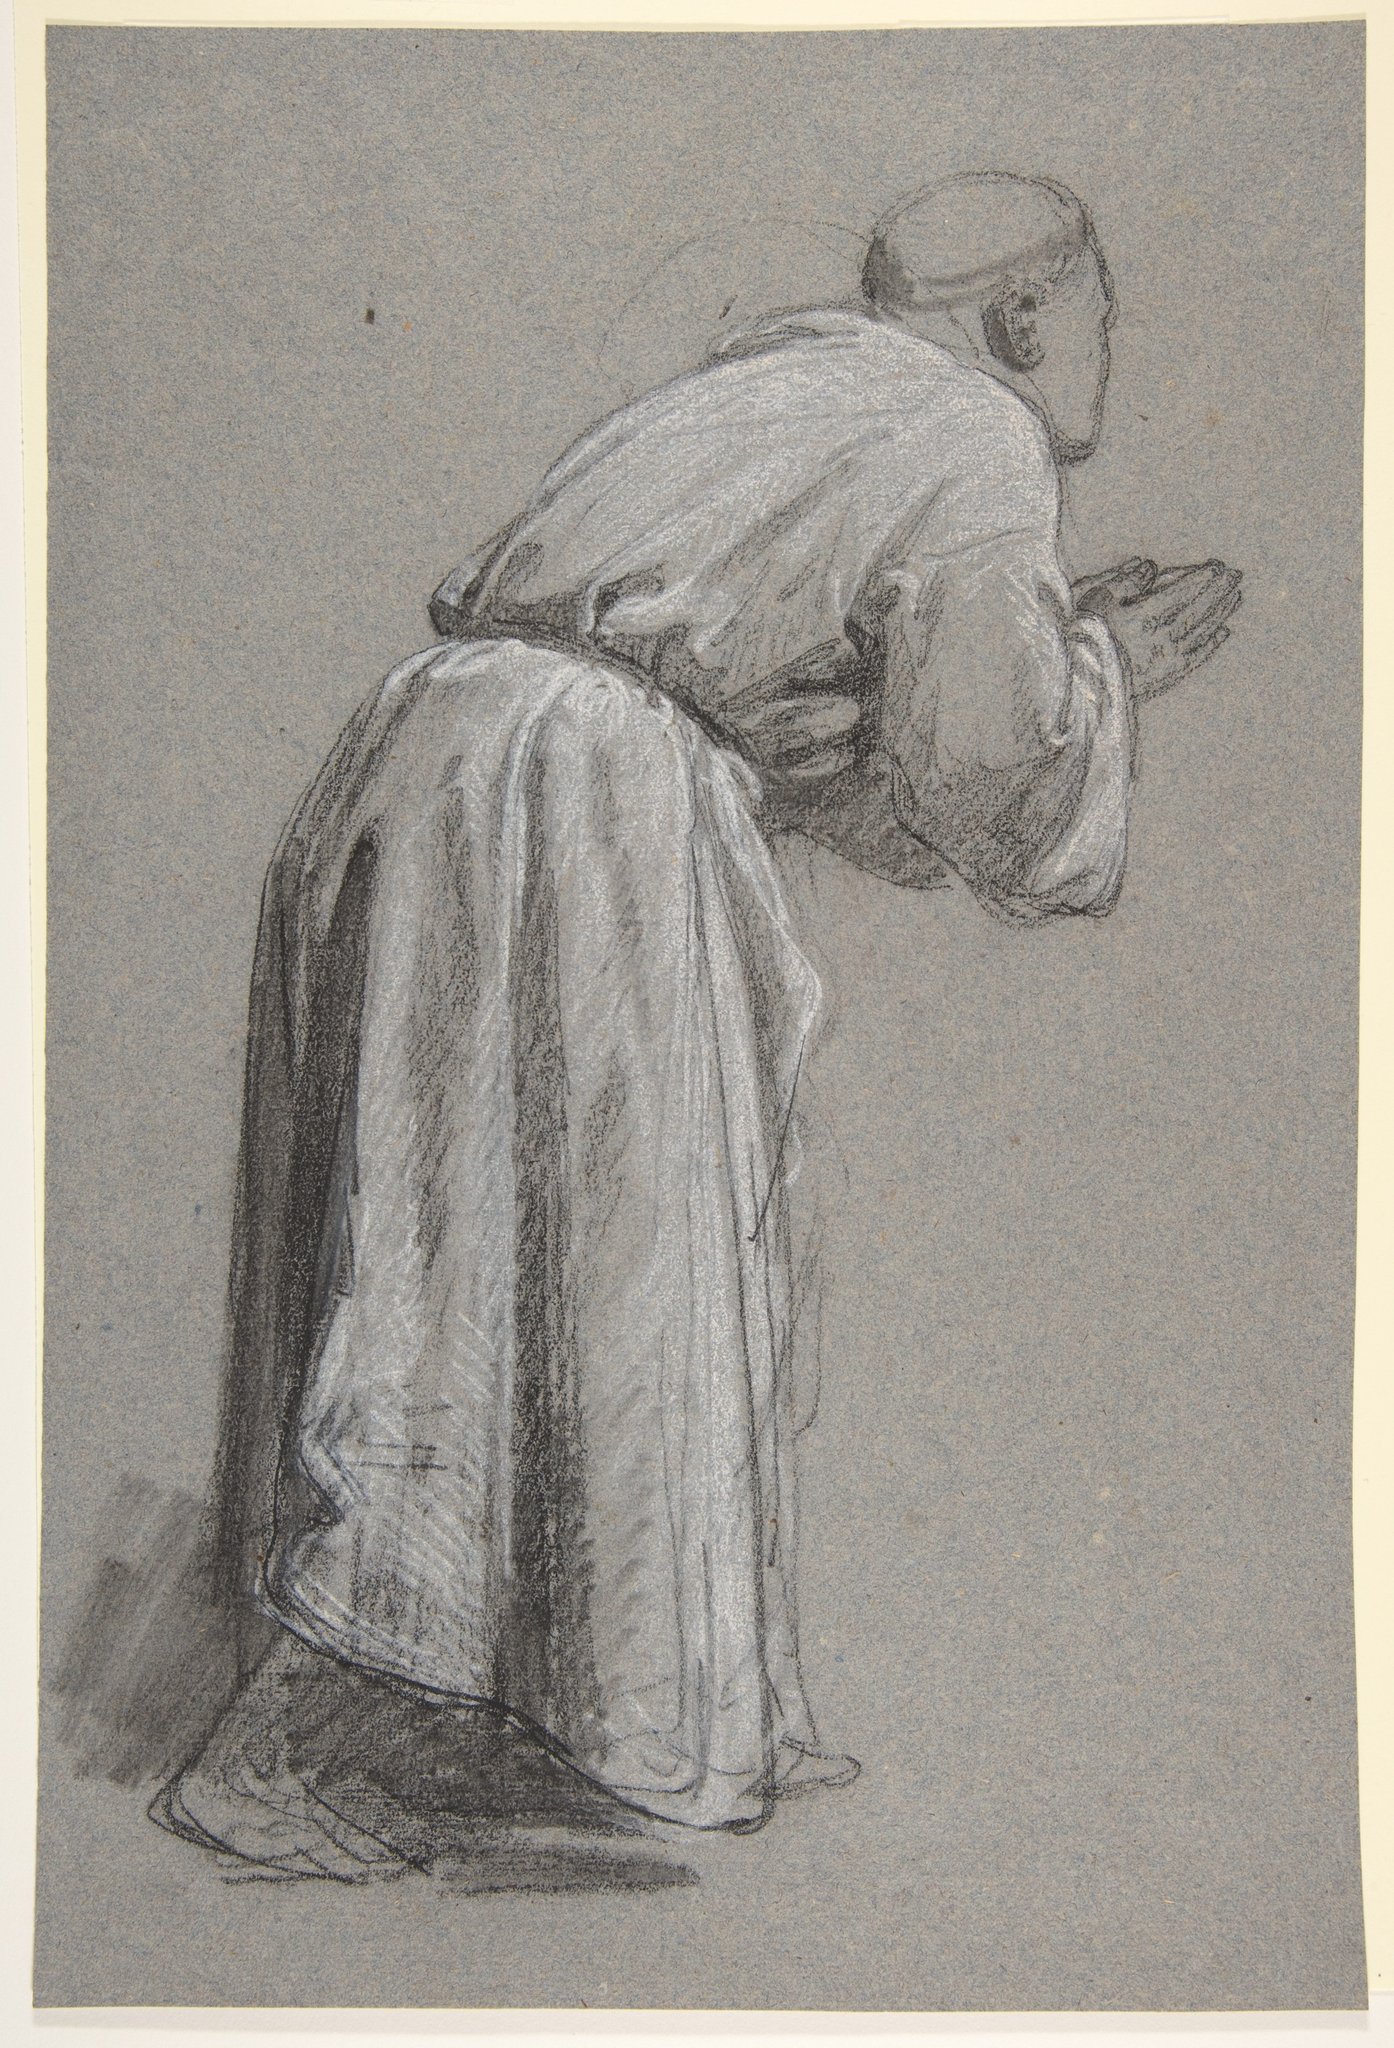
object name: drawing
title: Cleric with Joined Hands (lower register?); verso: (same figure); (studies for wall paintings in the Chapel of Saint Remi, Sainte-Clotilde, Paris, 1858)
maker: isidore pils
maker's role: artist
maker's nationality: french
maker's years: 1813-1875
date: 1801-1900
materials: chalk, paper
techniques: stumping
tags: men